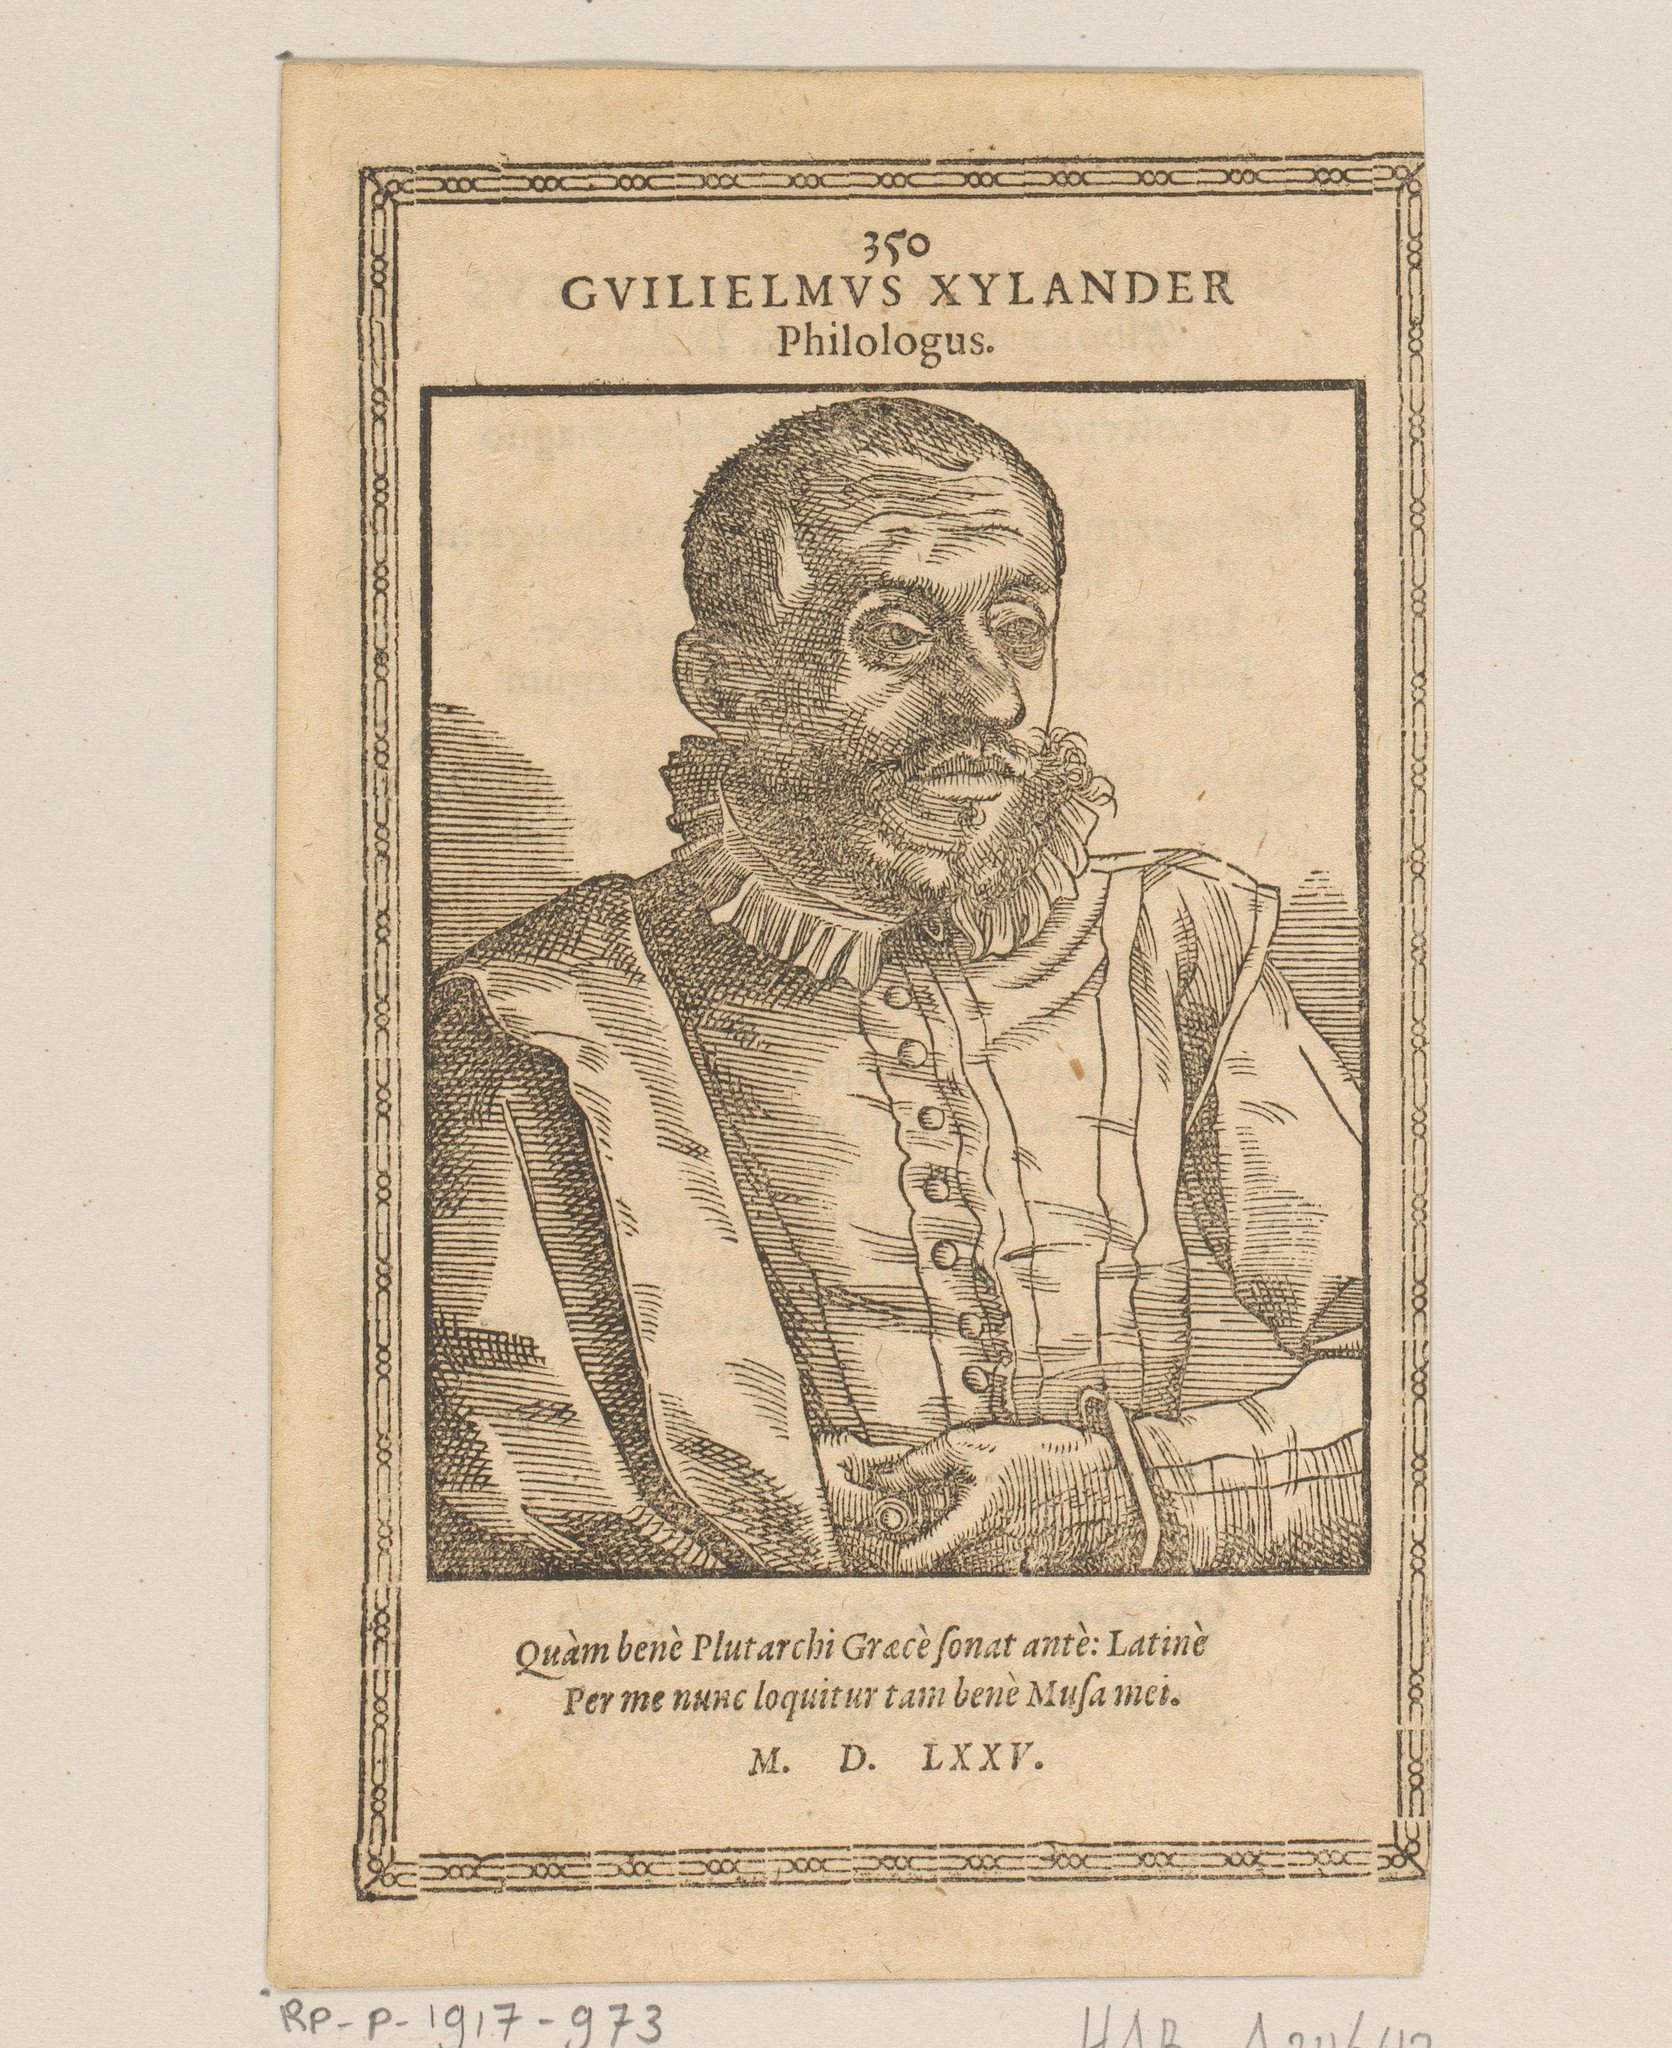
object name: book illustration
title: Portret van Wilhelmus Xylander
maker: bernhard jobin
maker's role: printer, publisher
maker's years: 1545-1593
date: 1590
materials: paper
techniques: letterpress printing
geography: straatsburg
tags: augsburg, scholar, philosopher, historical persons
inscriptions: collector's mark: Lugt 2228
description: Prent uit: Reusner, Nikolaus. Icones sive imagines virorum literis illustrium (...). Straatsburg: Bernhard Jobin, 1590, p. 350. Prent voor het eerst verschenen in de eerste editie van 1587. Prent ook gebruikt in latere publicaties.